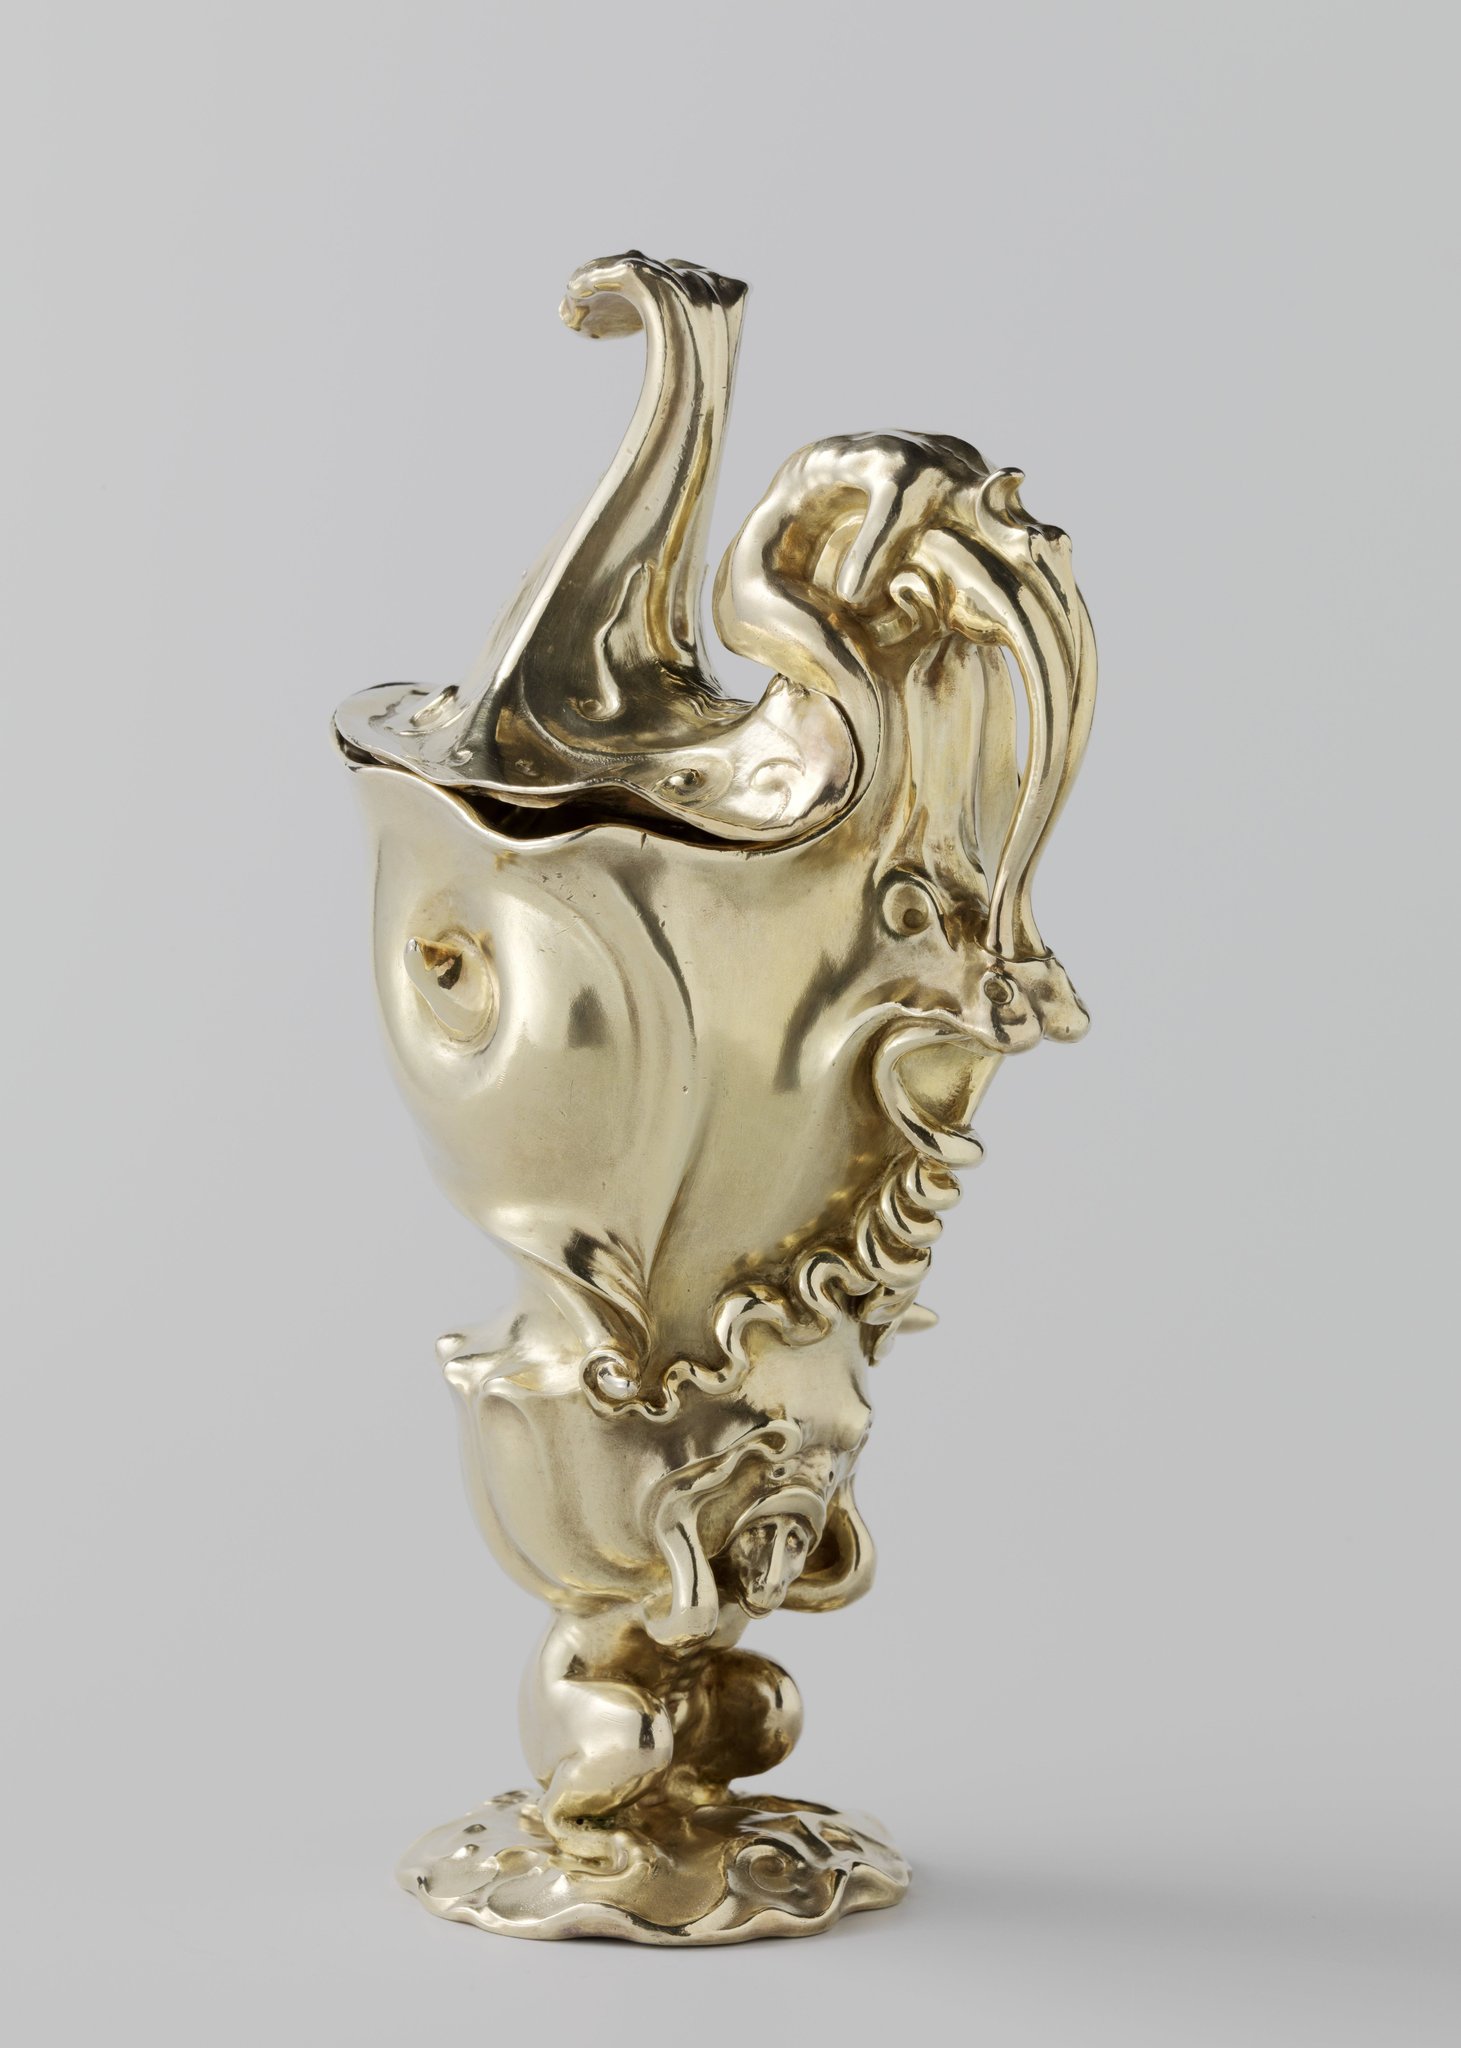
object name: ewer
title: Lidded ewer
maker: adam van vianen (i)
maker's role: draughtsman, print maker, silversmith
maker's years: 1568-1627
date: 1614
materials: silver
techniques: gilding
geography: utrecht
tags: prague, jeweler, paulus willemsz. van vianen, bending figure - aa - female human figure, monkeys, apes, amsterdam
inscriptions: duty mark, date letter: ‘T’, town mark, signature and date: ‘A.D.Viana.FE. Ao 1614’, maker's mark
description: On this ewer everything is in motion. Animal and human forms emerge from a viscous mass. It is possible that it represents the primordial soup (prima matera) from which life arose according to alchemists. On the inside are two crawling salamanders or lizards: animals that were also thought to originate from non-living matter. Does the ewer establish a link between the creative power of the artist and that of nature?